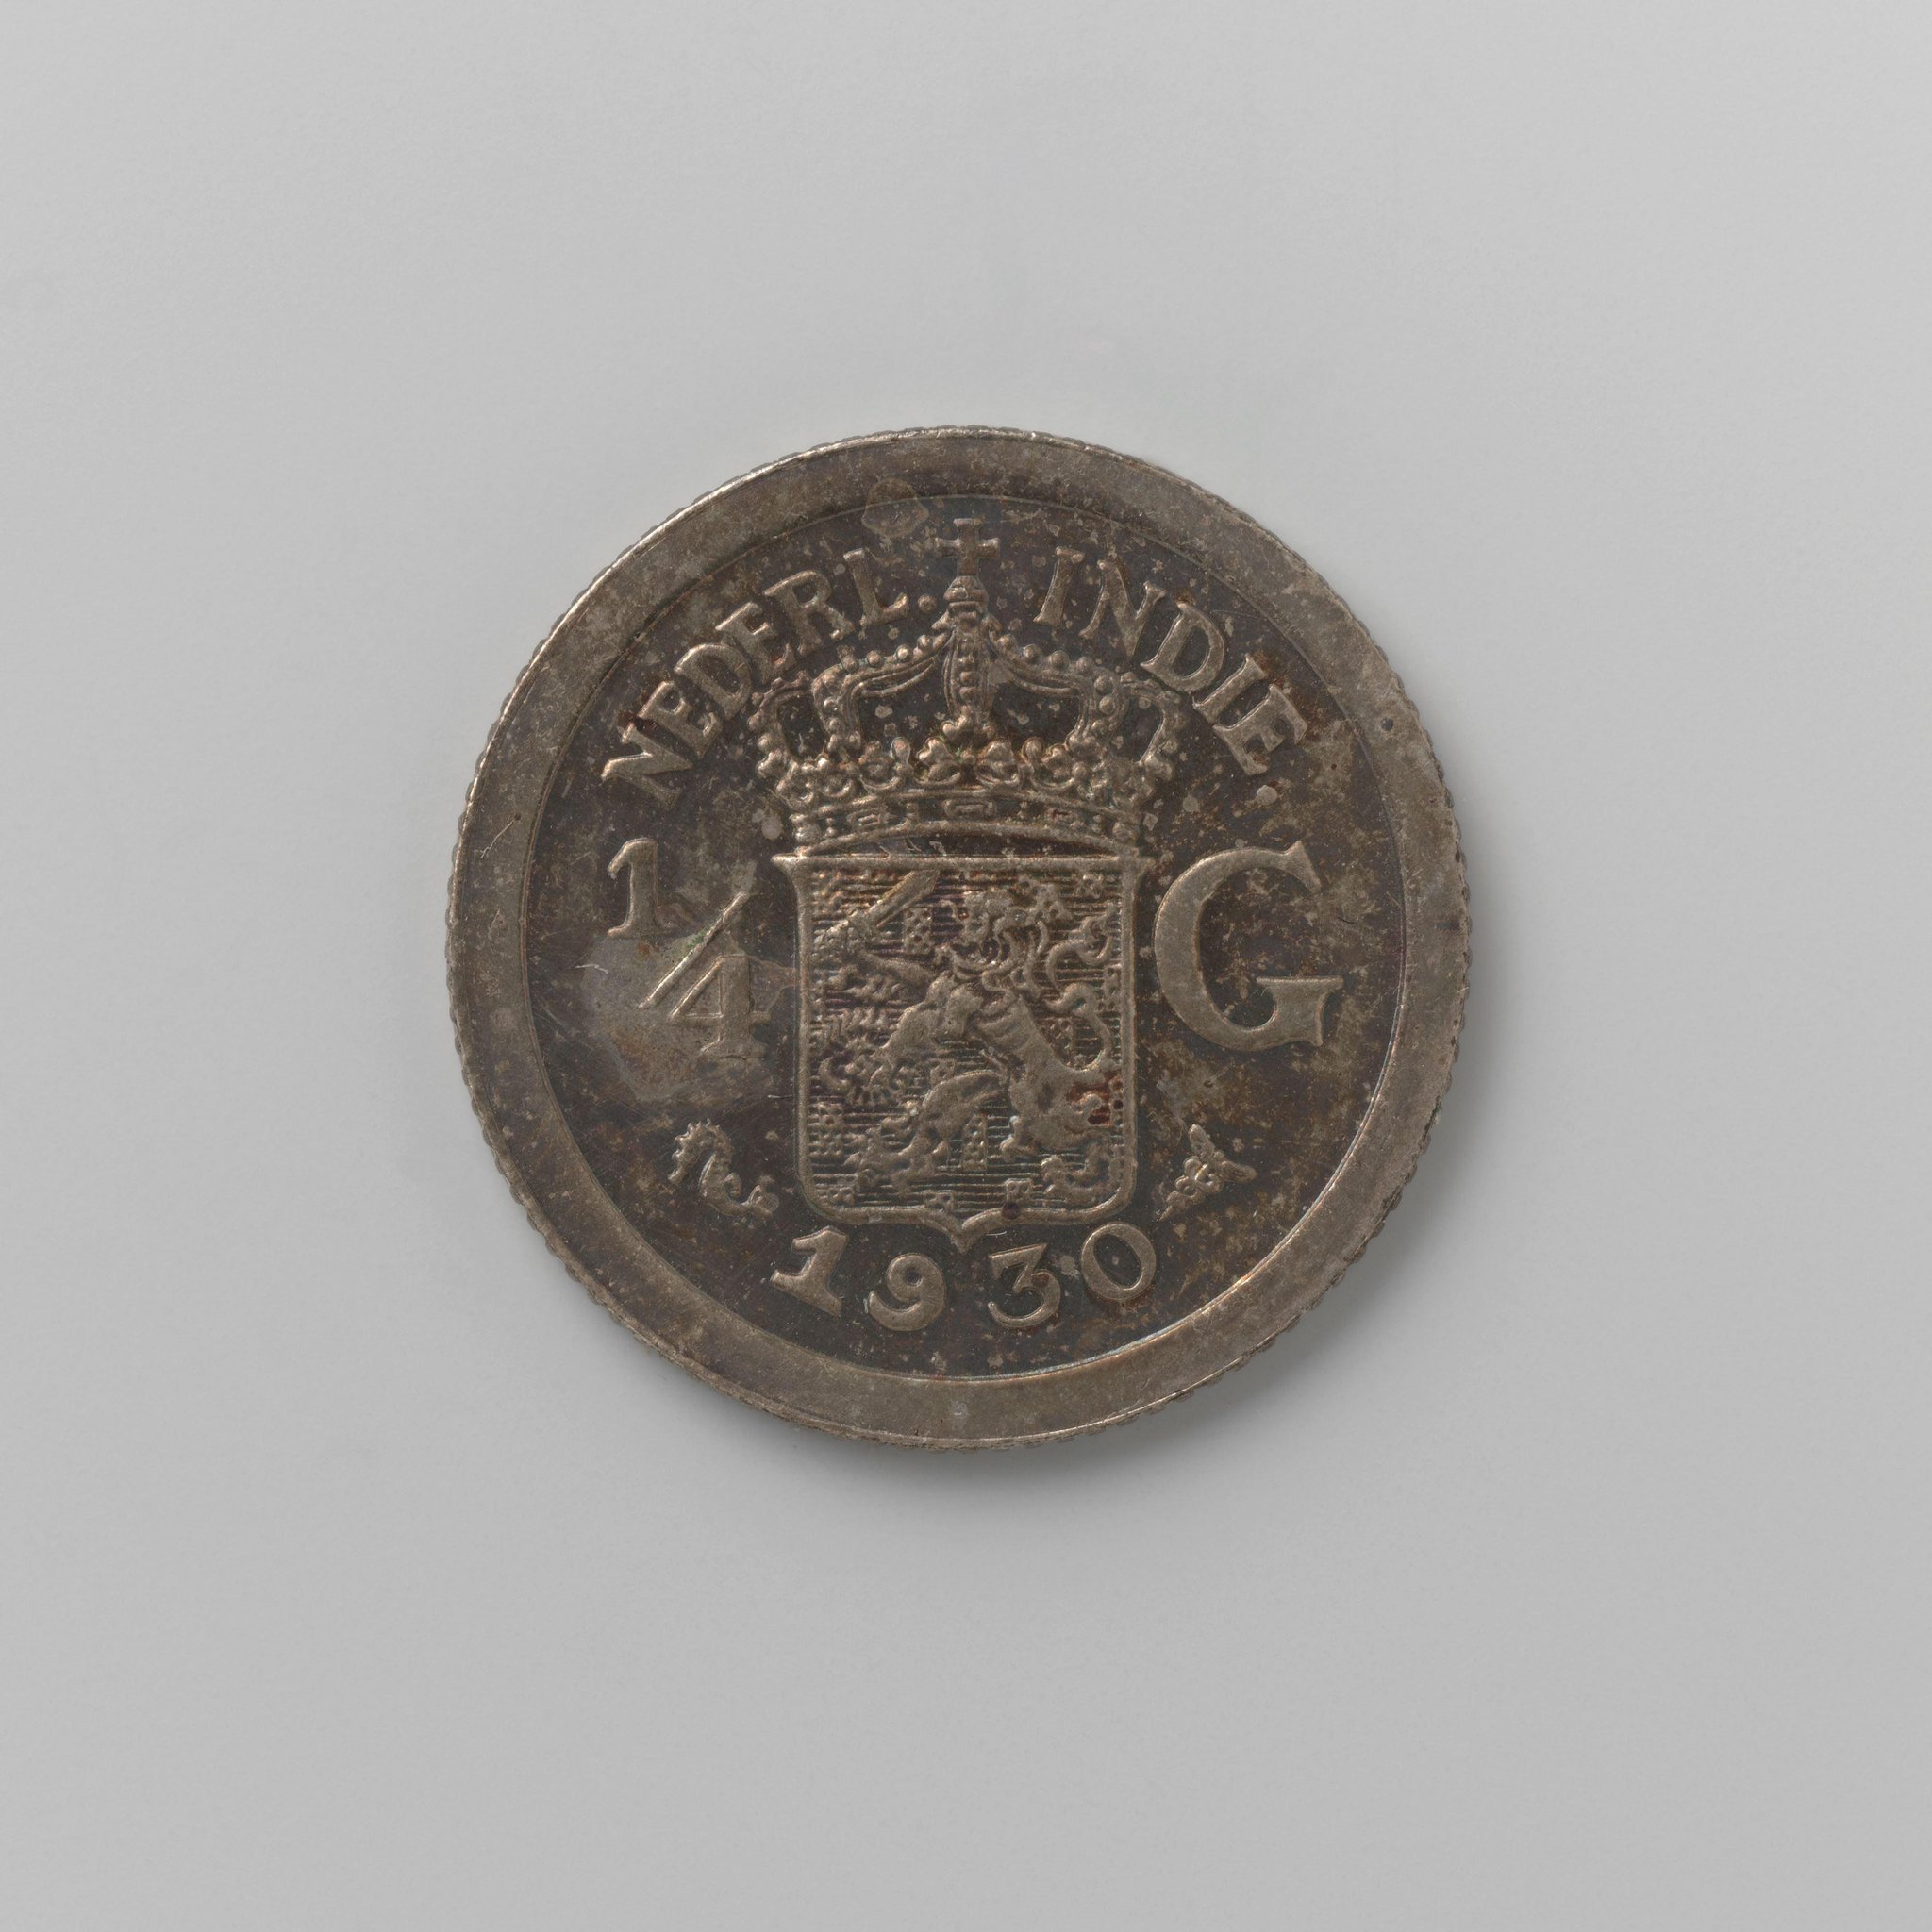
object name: coin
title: Nederlands Indië,1/4 gulden,1930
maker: wilhelmina of the netherlands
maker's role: print maker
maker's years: 1880-1962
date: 1930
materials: silver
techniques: striking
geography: utrecht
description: Zilveren munt. Voorzijde: tussen waarde-aanduiding 1/4 G gekroond rijkswapenschild. Boven kroon landsaanduiding en onder wapenschild jaartal. Keerzijde: drieregelig Maleis opschrift in Arabische tekens, waaromheen tussen zeven uitschietende stralen omschrift in het Javaans. Kartelrand.